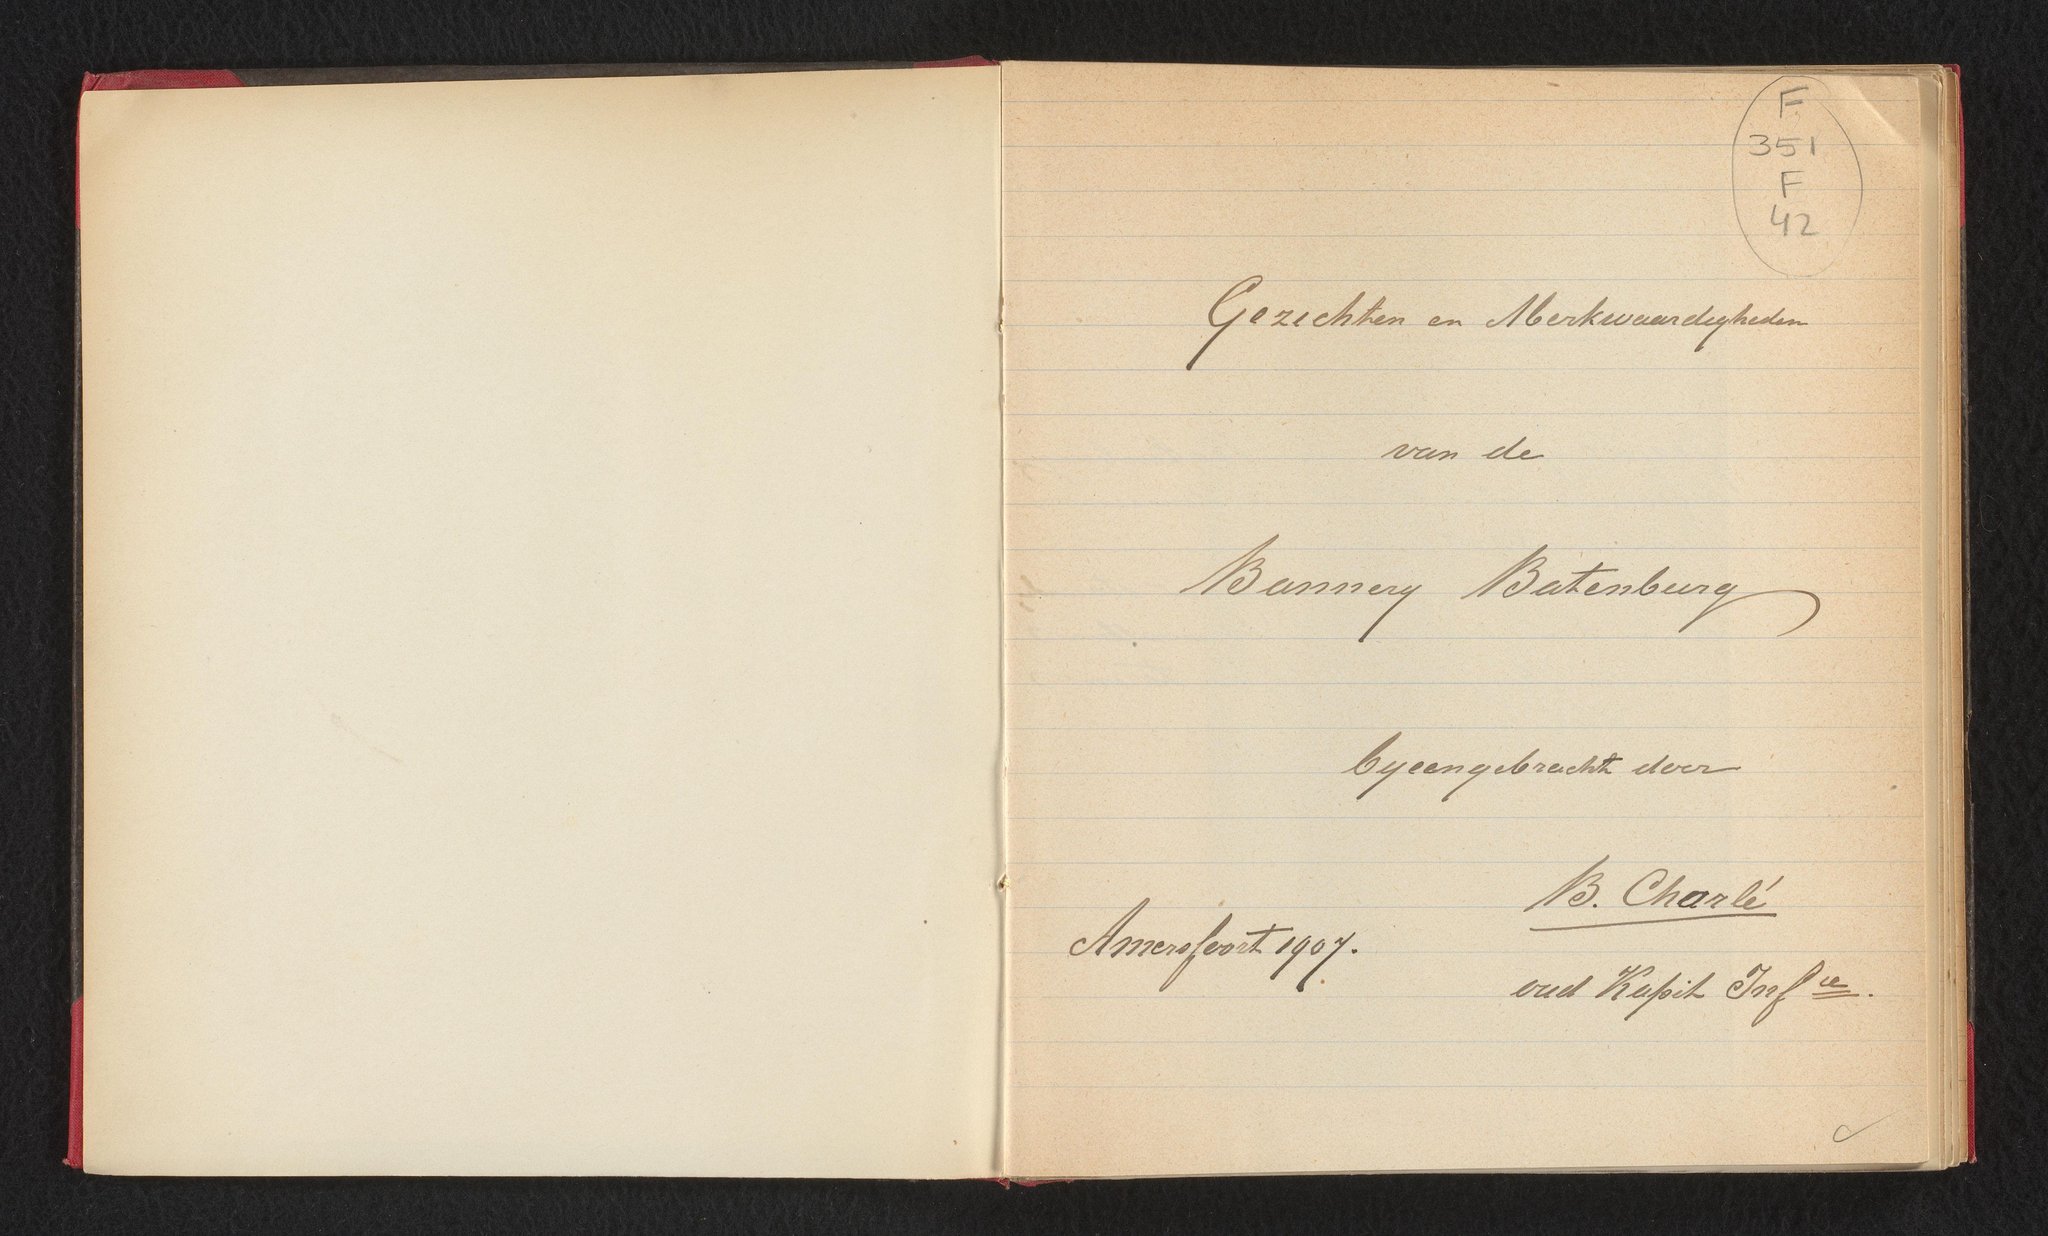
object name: book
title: Gezichten en merkwaardigheden van de bannery Batenburg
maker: benjamin charlé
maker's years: 1845-1925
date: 1907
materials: paper, cardboard, textile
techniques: pen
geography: amersfoort